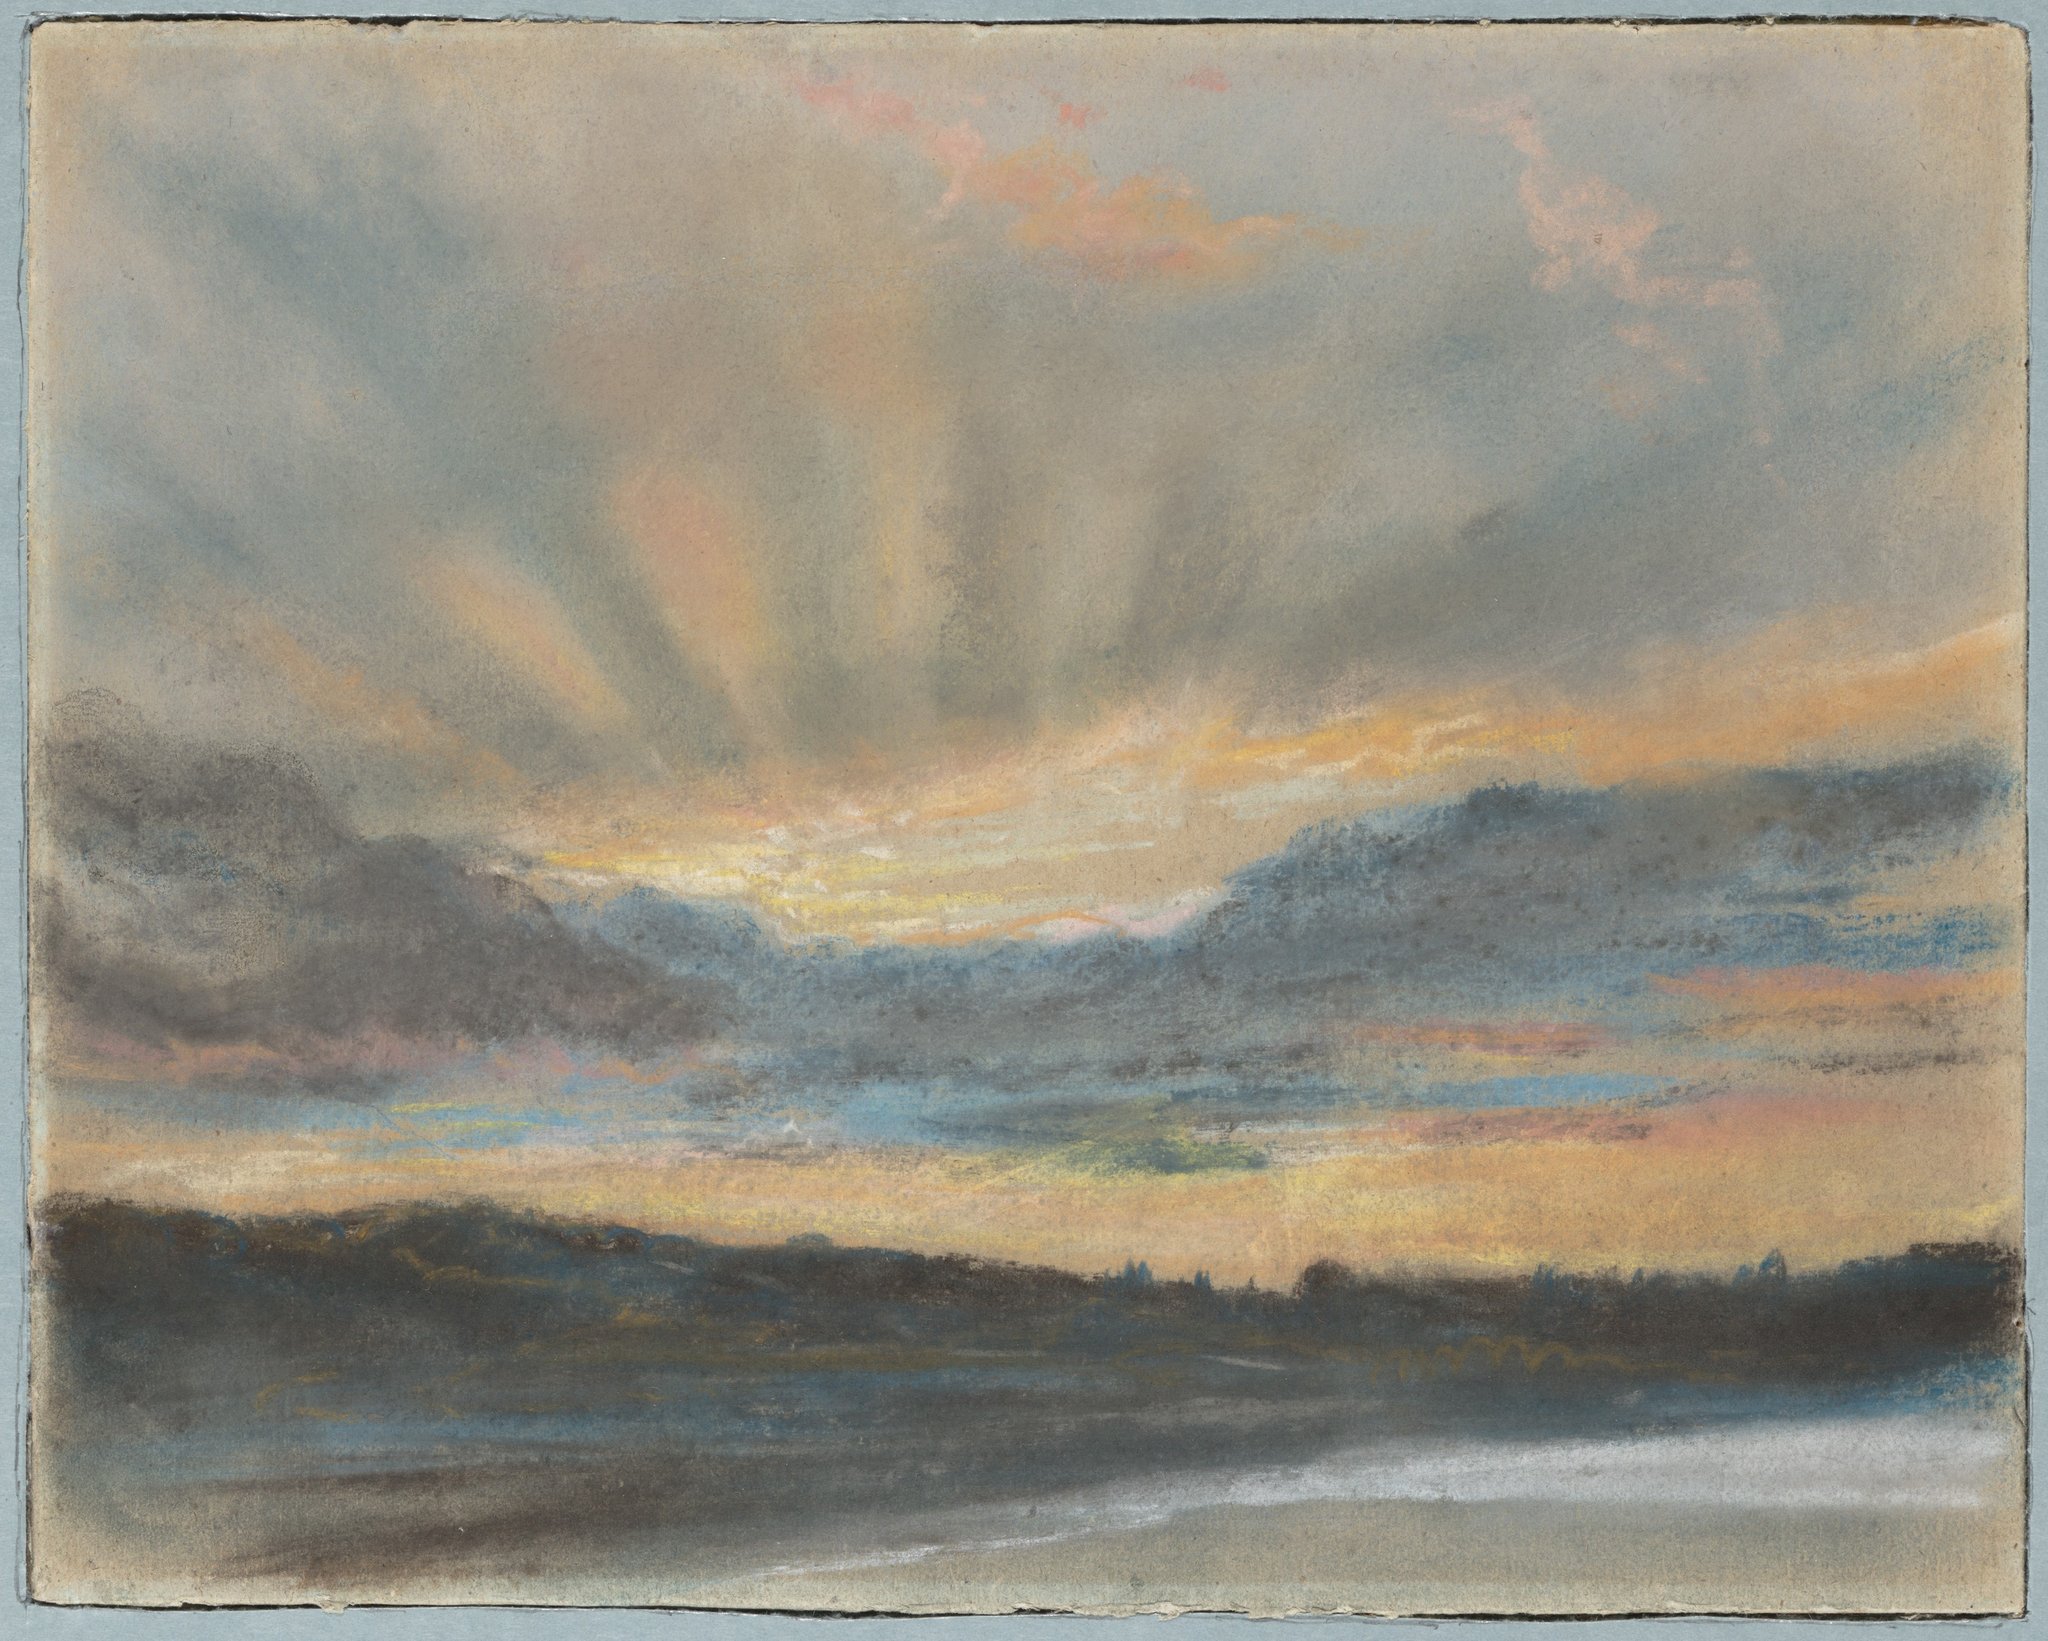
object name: drawing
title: Sunset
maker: eugène delacroix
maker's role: artist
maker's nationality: french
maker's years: 1798-1863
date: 1850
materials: paper, pastel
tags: landscapes